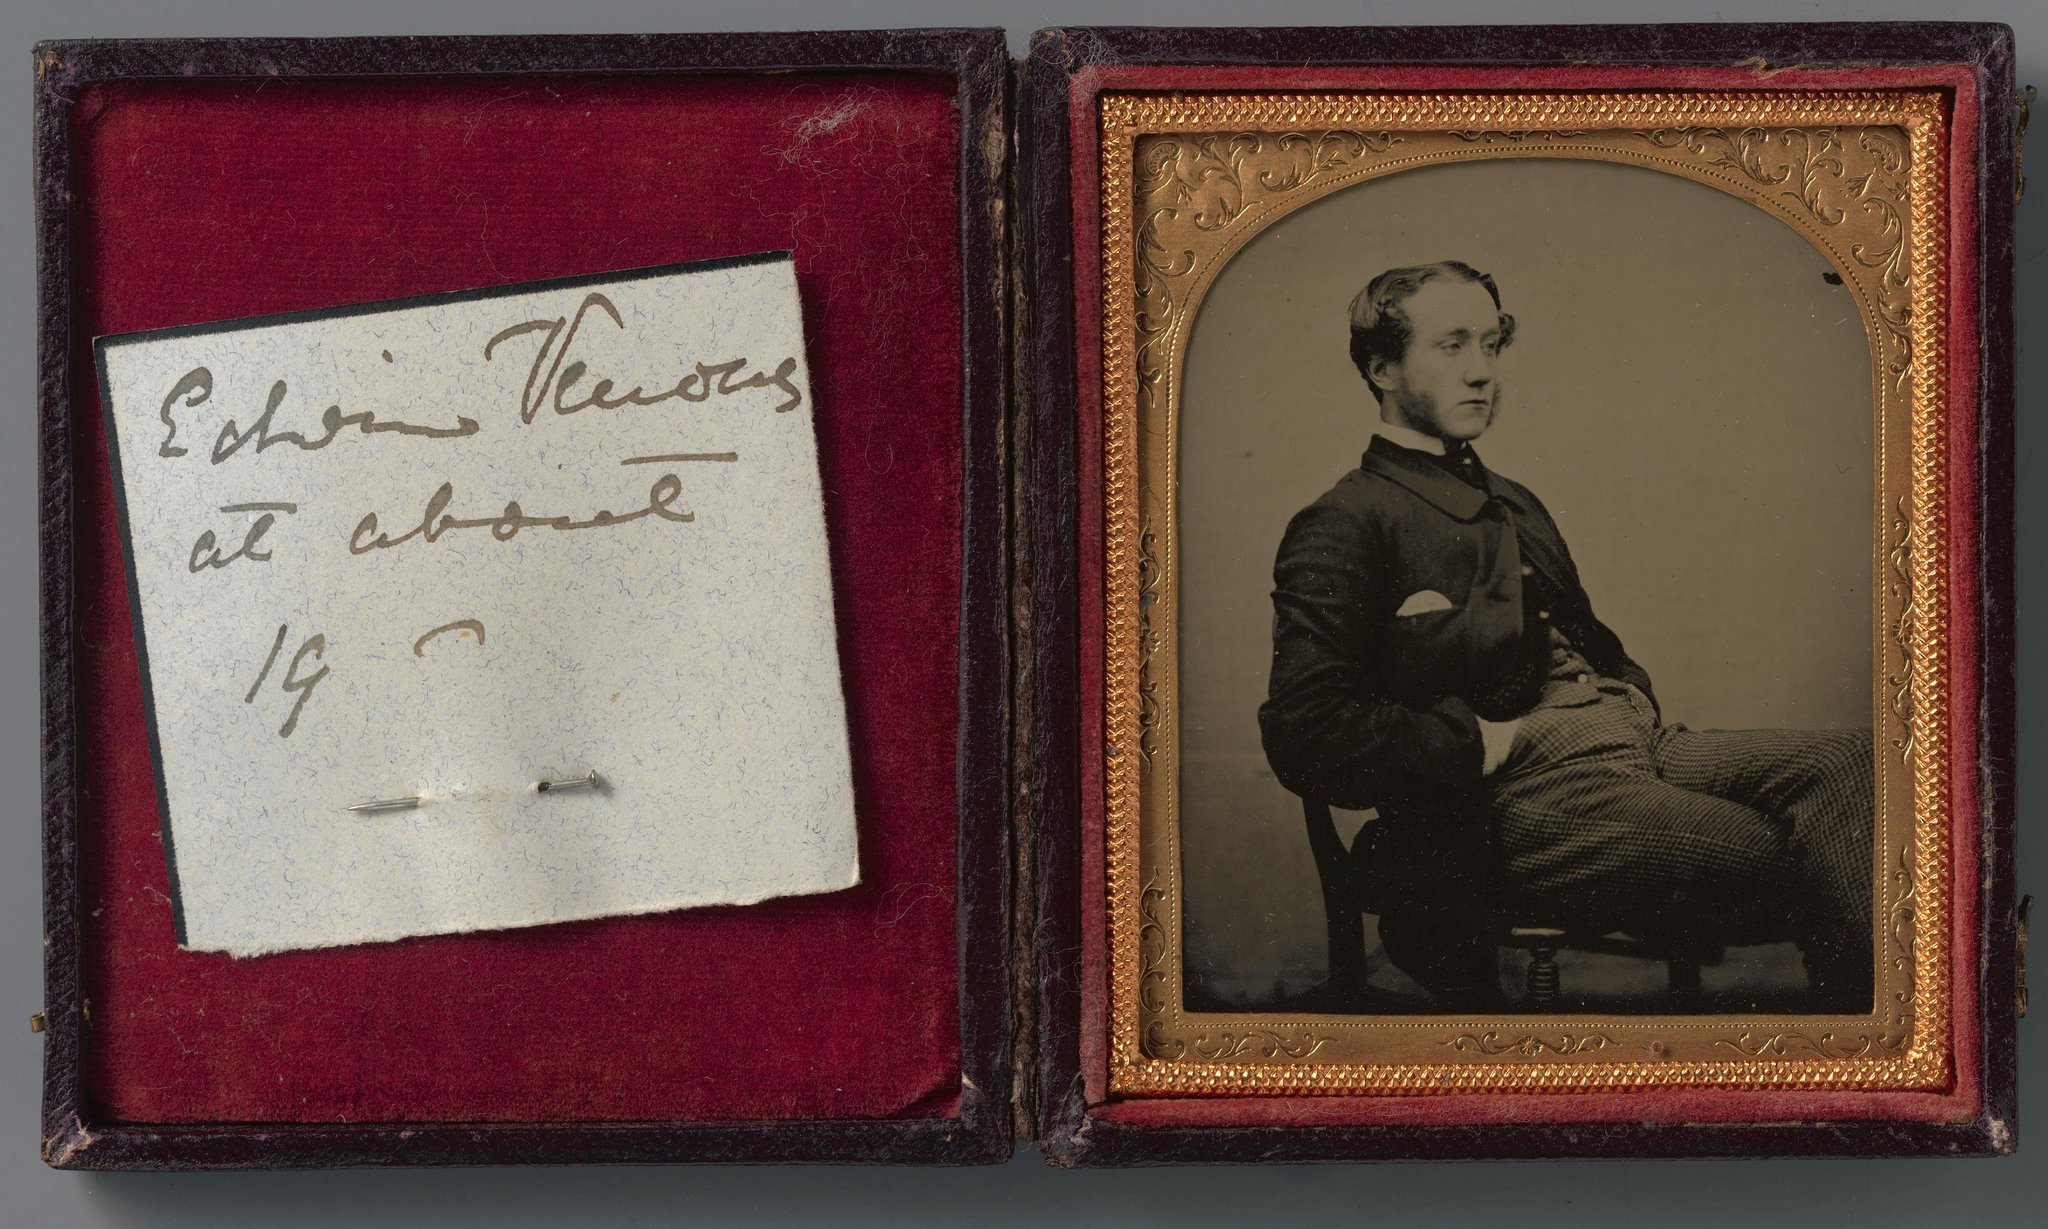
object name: photograph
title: Portret van een zittende jongeman, aangeduid als Edwin Venous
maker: bracher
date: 1857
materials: glass, metal, velvet, wood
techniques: ambrotype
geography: oxford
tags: sitting figure, historical persons, youth, adolescent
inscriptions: annotation: ‘Edwin Venous/ at about/ 19’